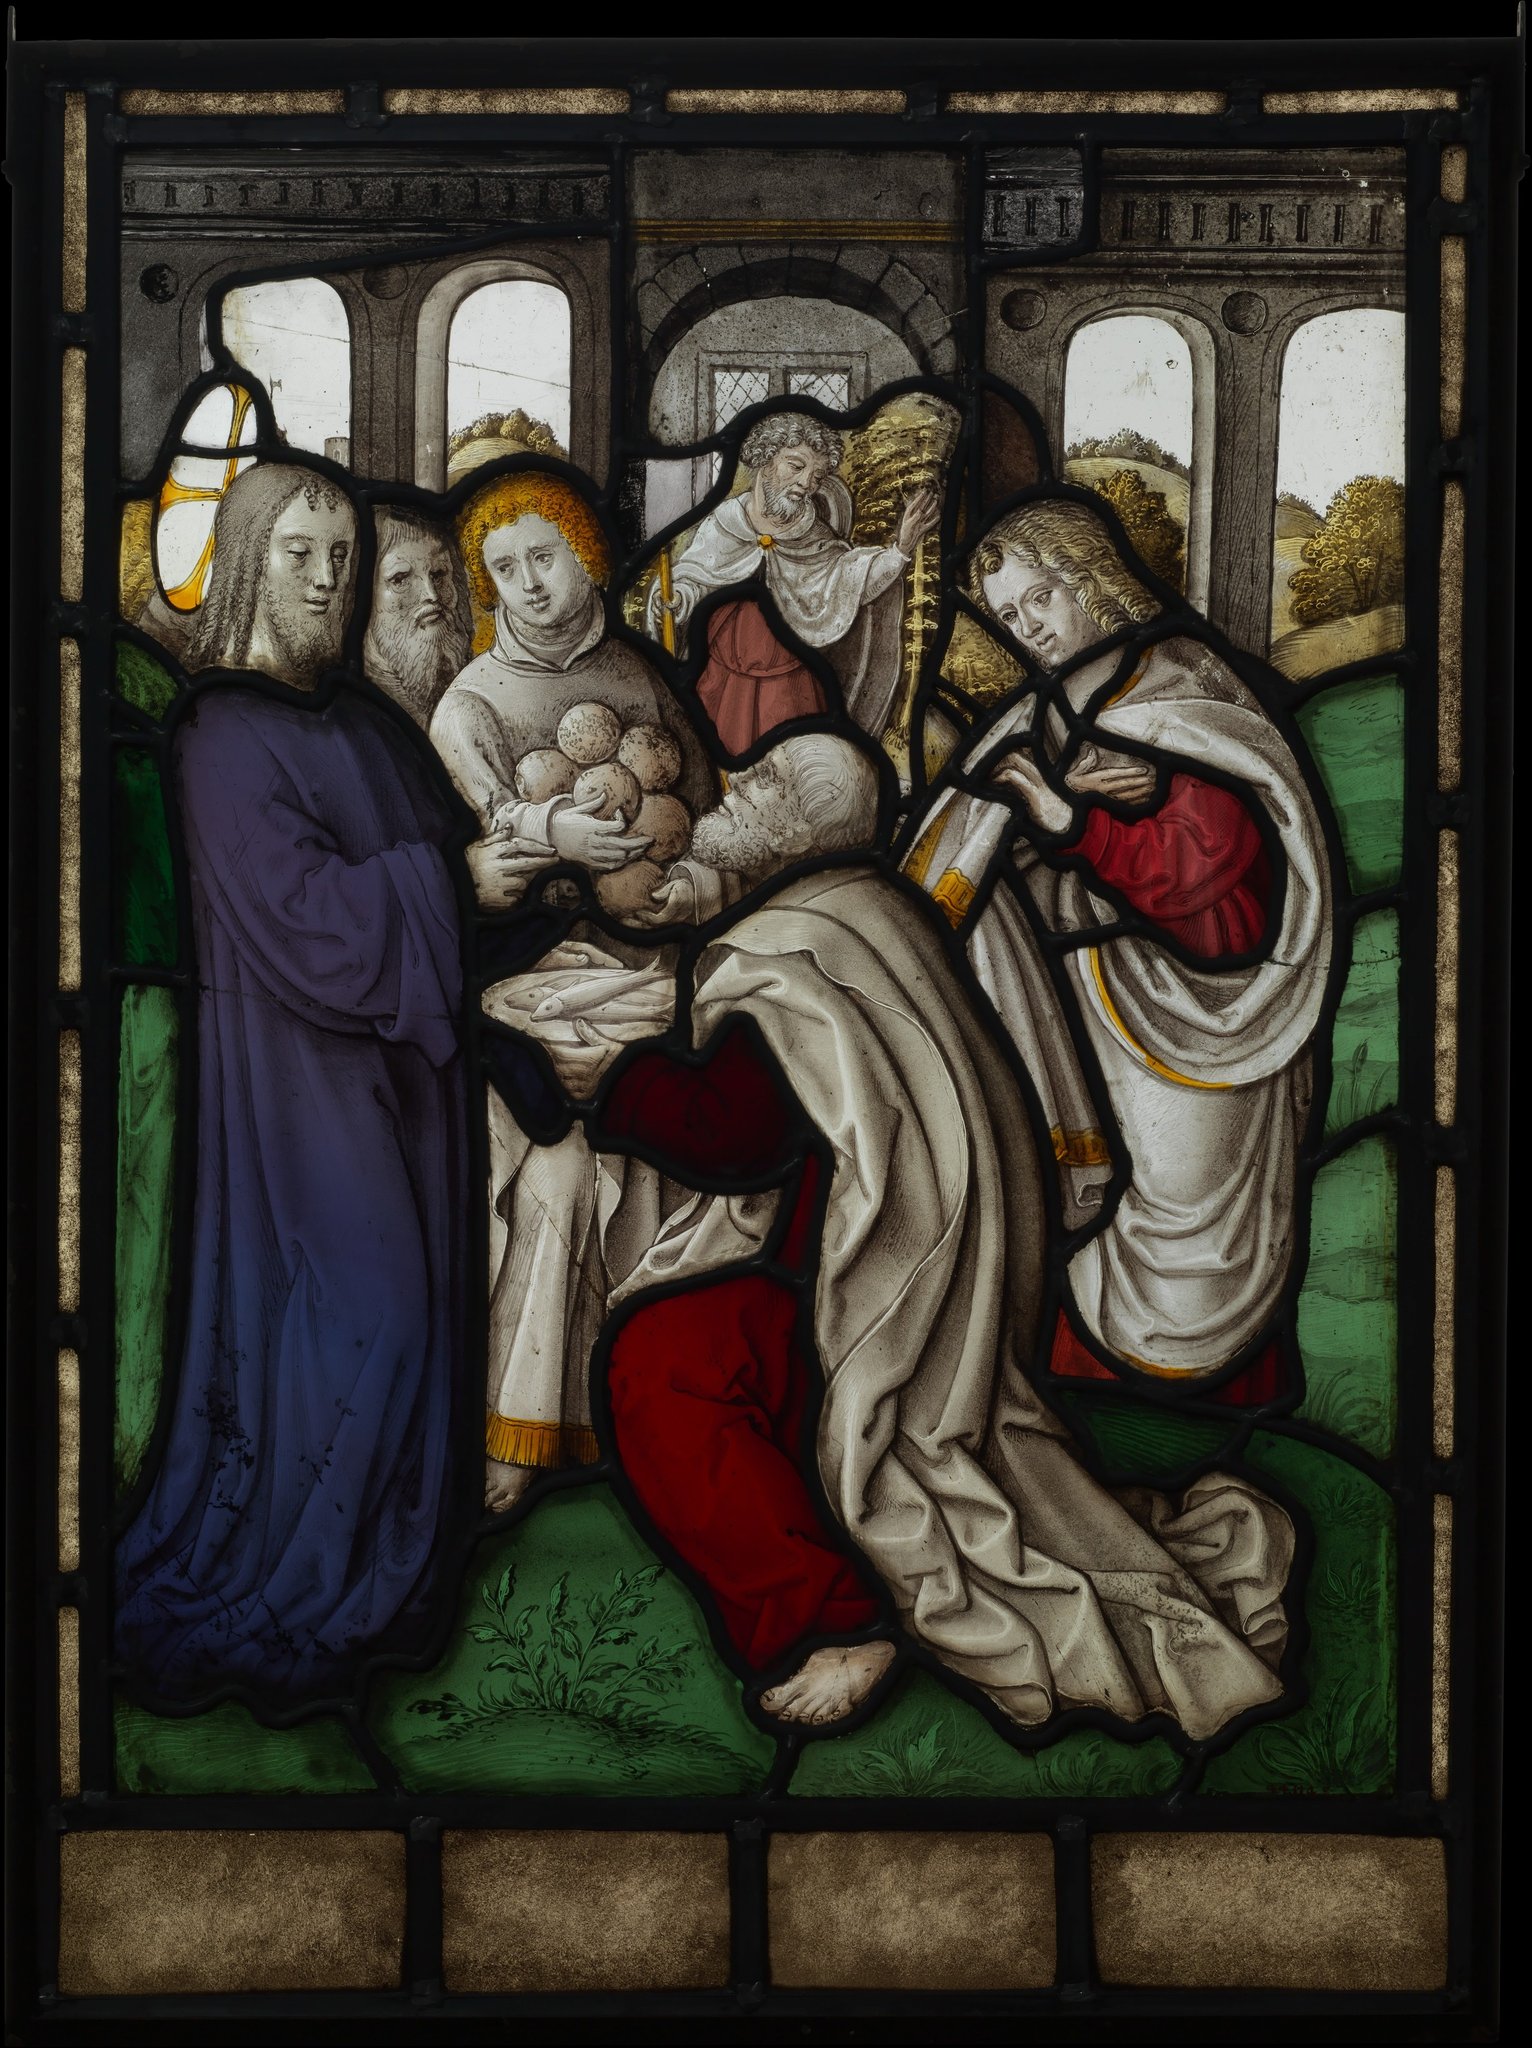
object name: panel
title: Miracle of the Loaves and Fishes (one of a set of 12 scenes from The Life of Christ)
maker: jan rombouts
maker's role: maker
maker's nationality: south netherlandish (duchy of brabant)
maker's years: 1475-1535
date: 1525-1530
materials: glass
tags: men,women,fish,christ